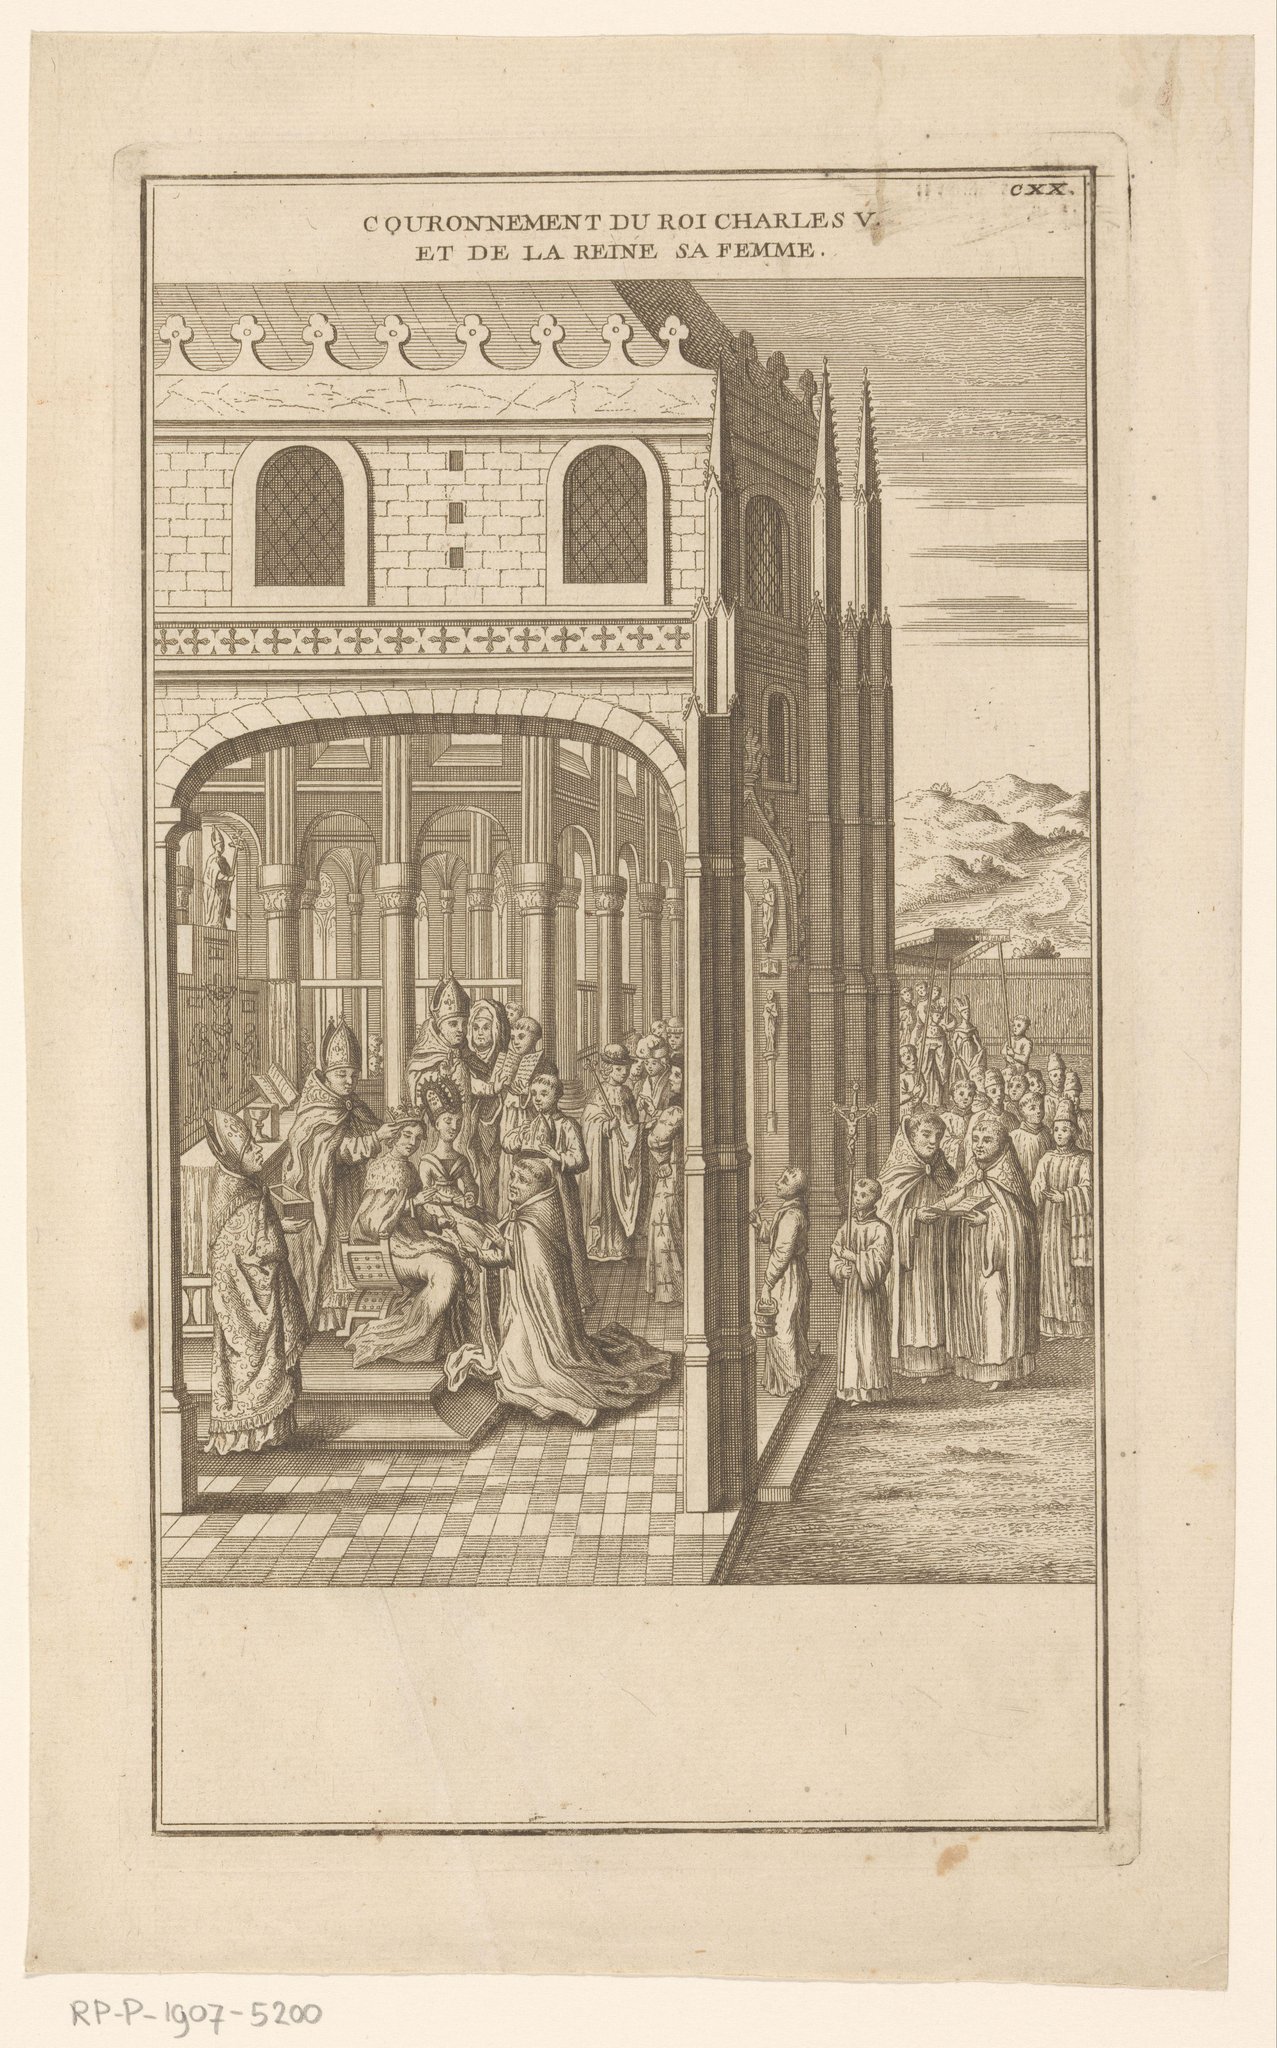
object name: print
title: Kroning van koning Karel V en zijn vrouw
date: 1729-1733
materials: paper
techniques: engraving, etching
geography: paris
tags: paris, coronation of a ruler, king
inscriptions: collector's mark: Lugt 2228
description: Prent uit: Montfaucon, Bernard de. Les monumens de la monarchie françoise, qui comprennent l'histoire de France avec les figures de chaque règne que l'injure des tems a épargnées (...). Parijs: Julien-Michel Gandouin en Pierre-François Giffart, 1729-1733, dl. 3, afb. voor p. 3.